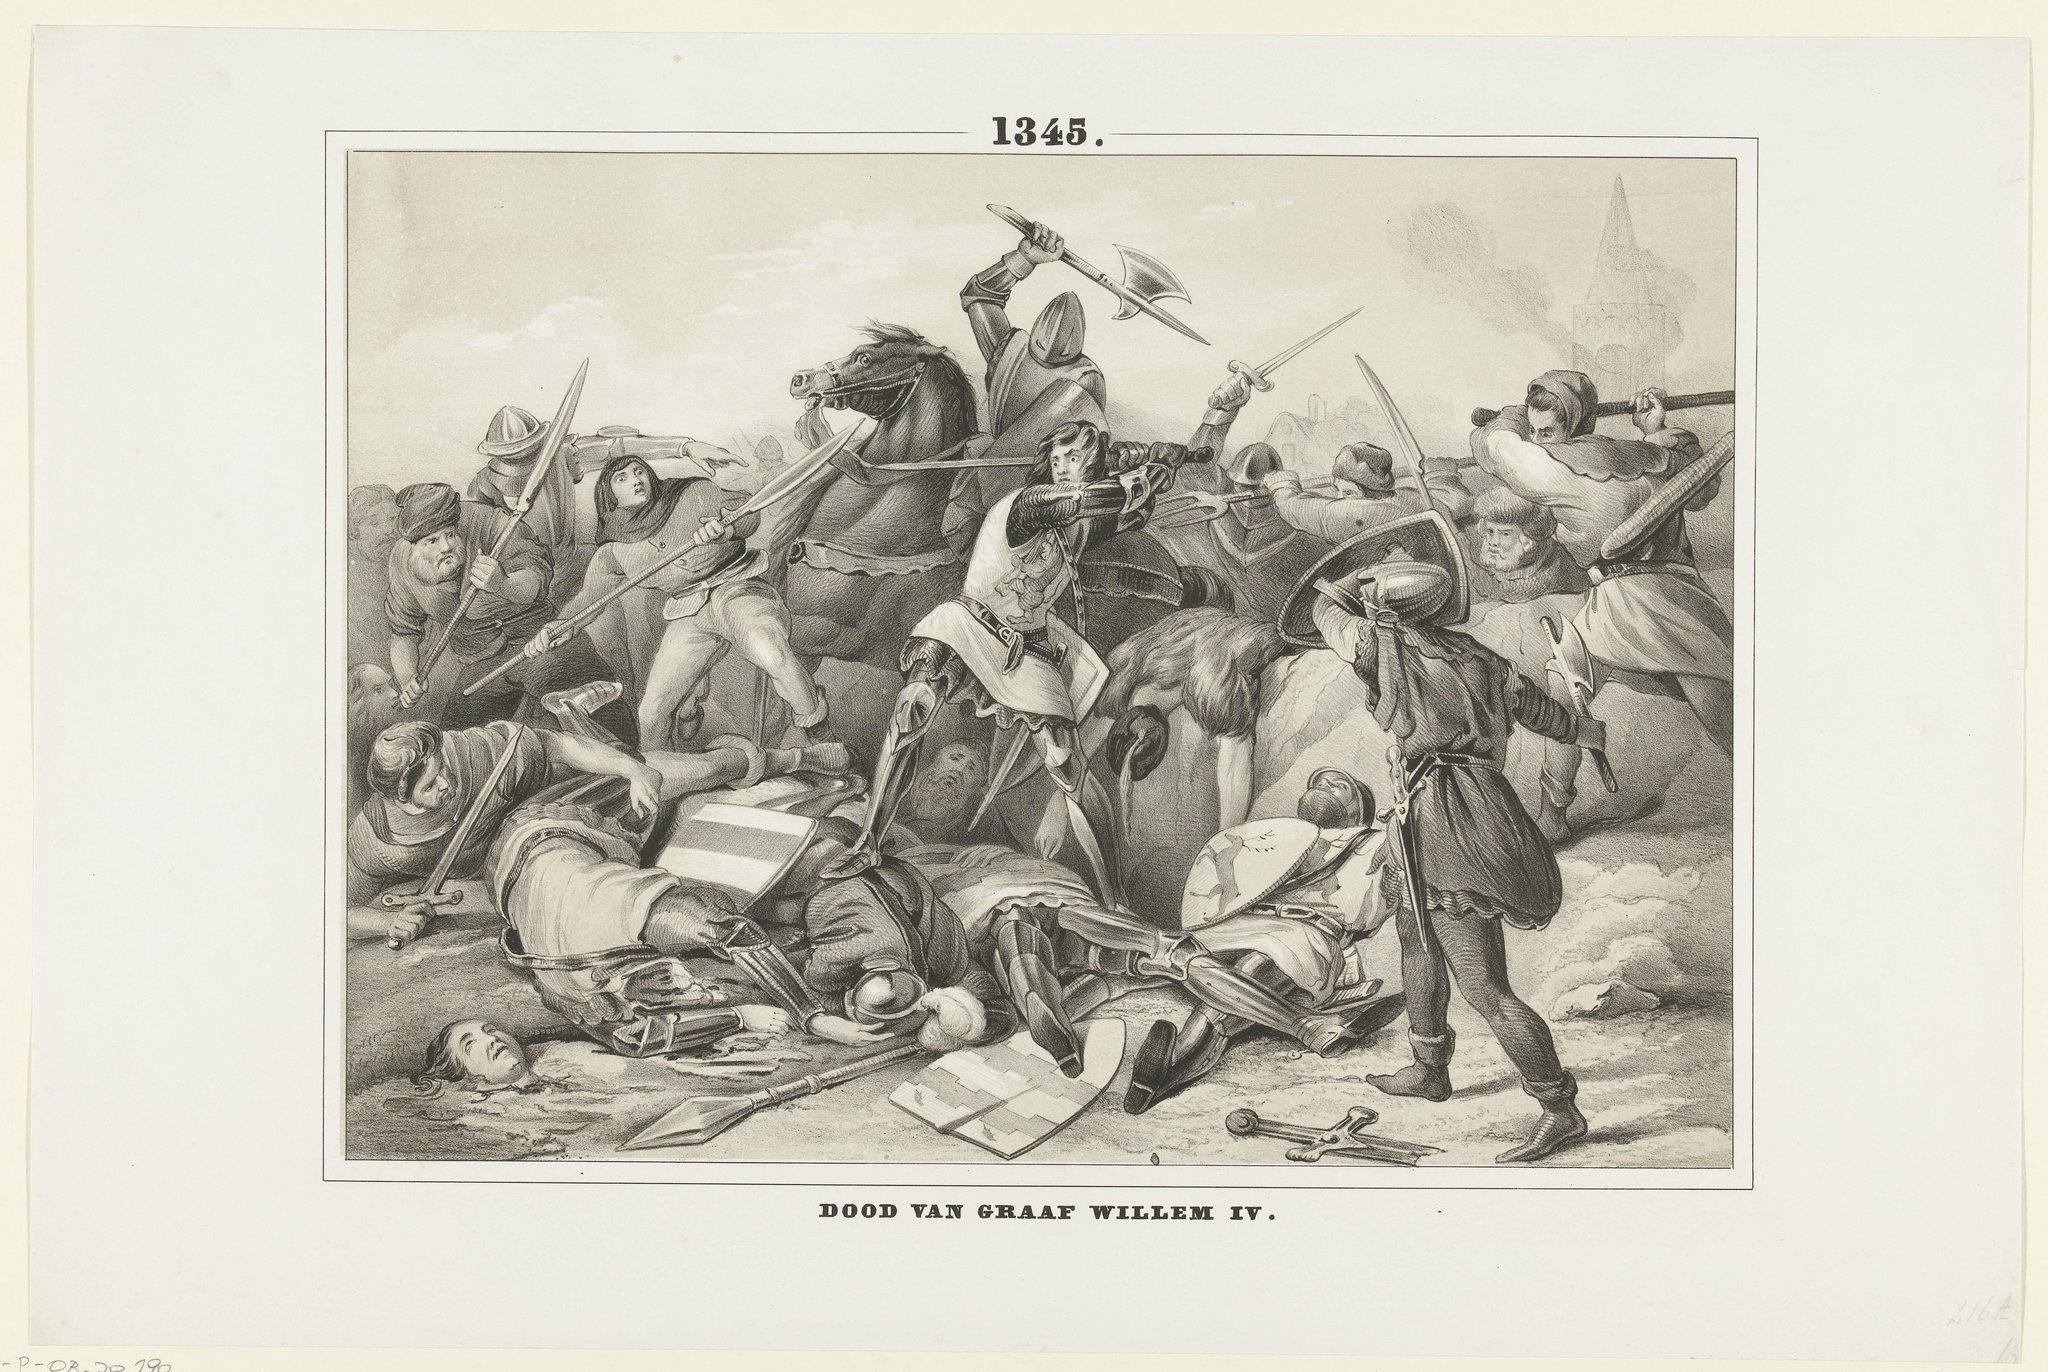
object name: history print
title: Dood van graaf Willem IV, 1345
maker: Anonymous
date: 1853-1855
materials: paper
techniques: lithograph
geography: netherlands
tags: willem iv (graaf van holland)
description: Illustratie voor: J.H. Eichman & H. Altmann, Vaderlandsche historieplaten voor scholen en huisgezinnen, Leiden, 1855. Dit nummer is een door het RPK toegevoegd nummer en staat niet in Frederik Muller, het werk waar de prent voor is gemaakt of uit afkomstig is, staat wel vermeld in Frederik Muller.